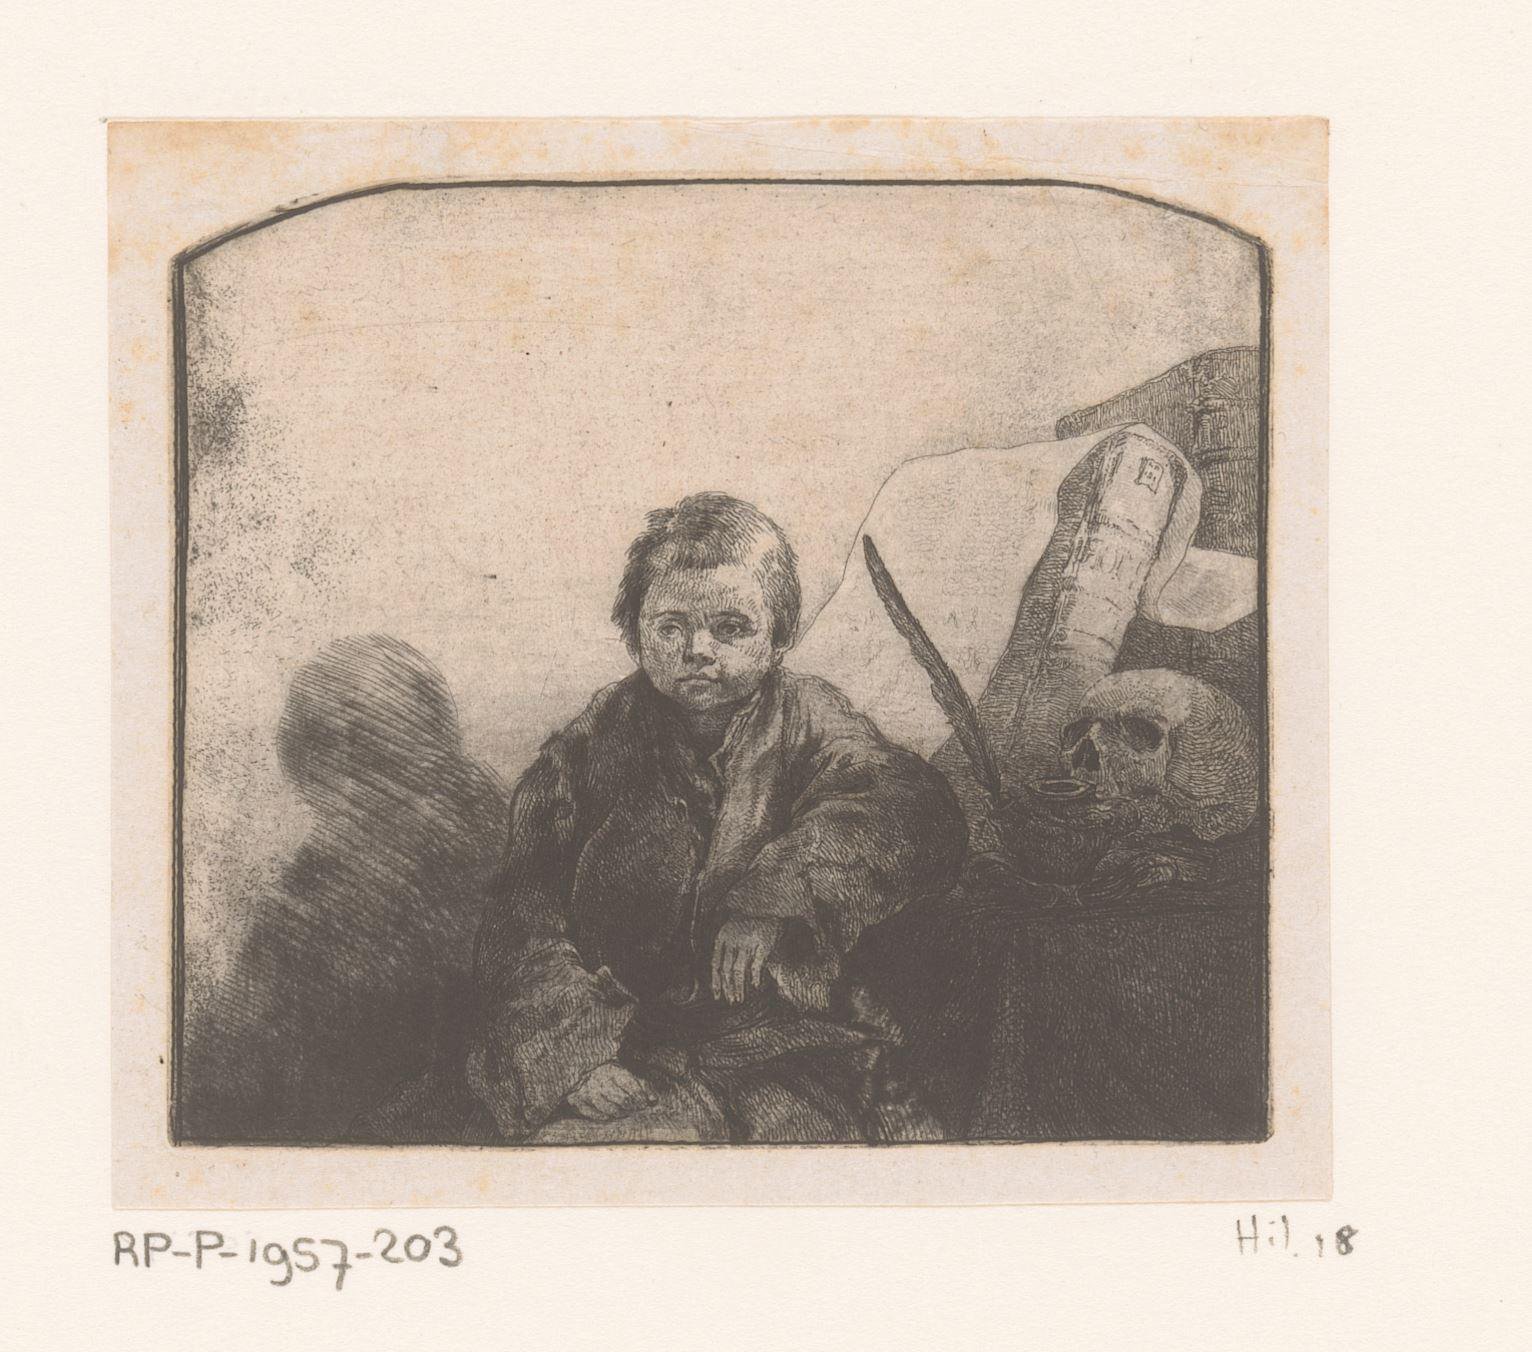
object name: print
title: Zittende jongen bij een tafel met boek en schedel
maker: jean pierre norblin de la gourdaine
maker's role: print maker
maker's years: 1745-1830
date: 1755-1830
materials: paper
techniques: etching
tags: scholar, philosopher, child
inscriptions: collector's mark: Lugt 2228